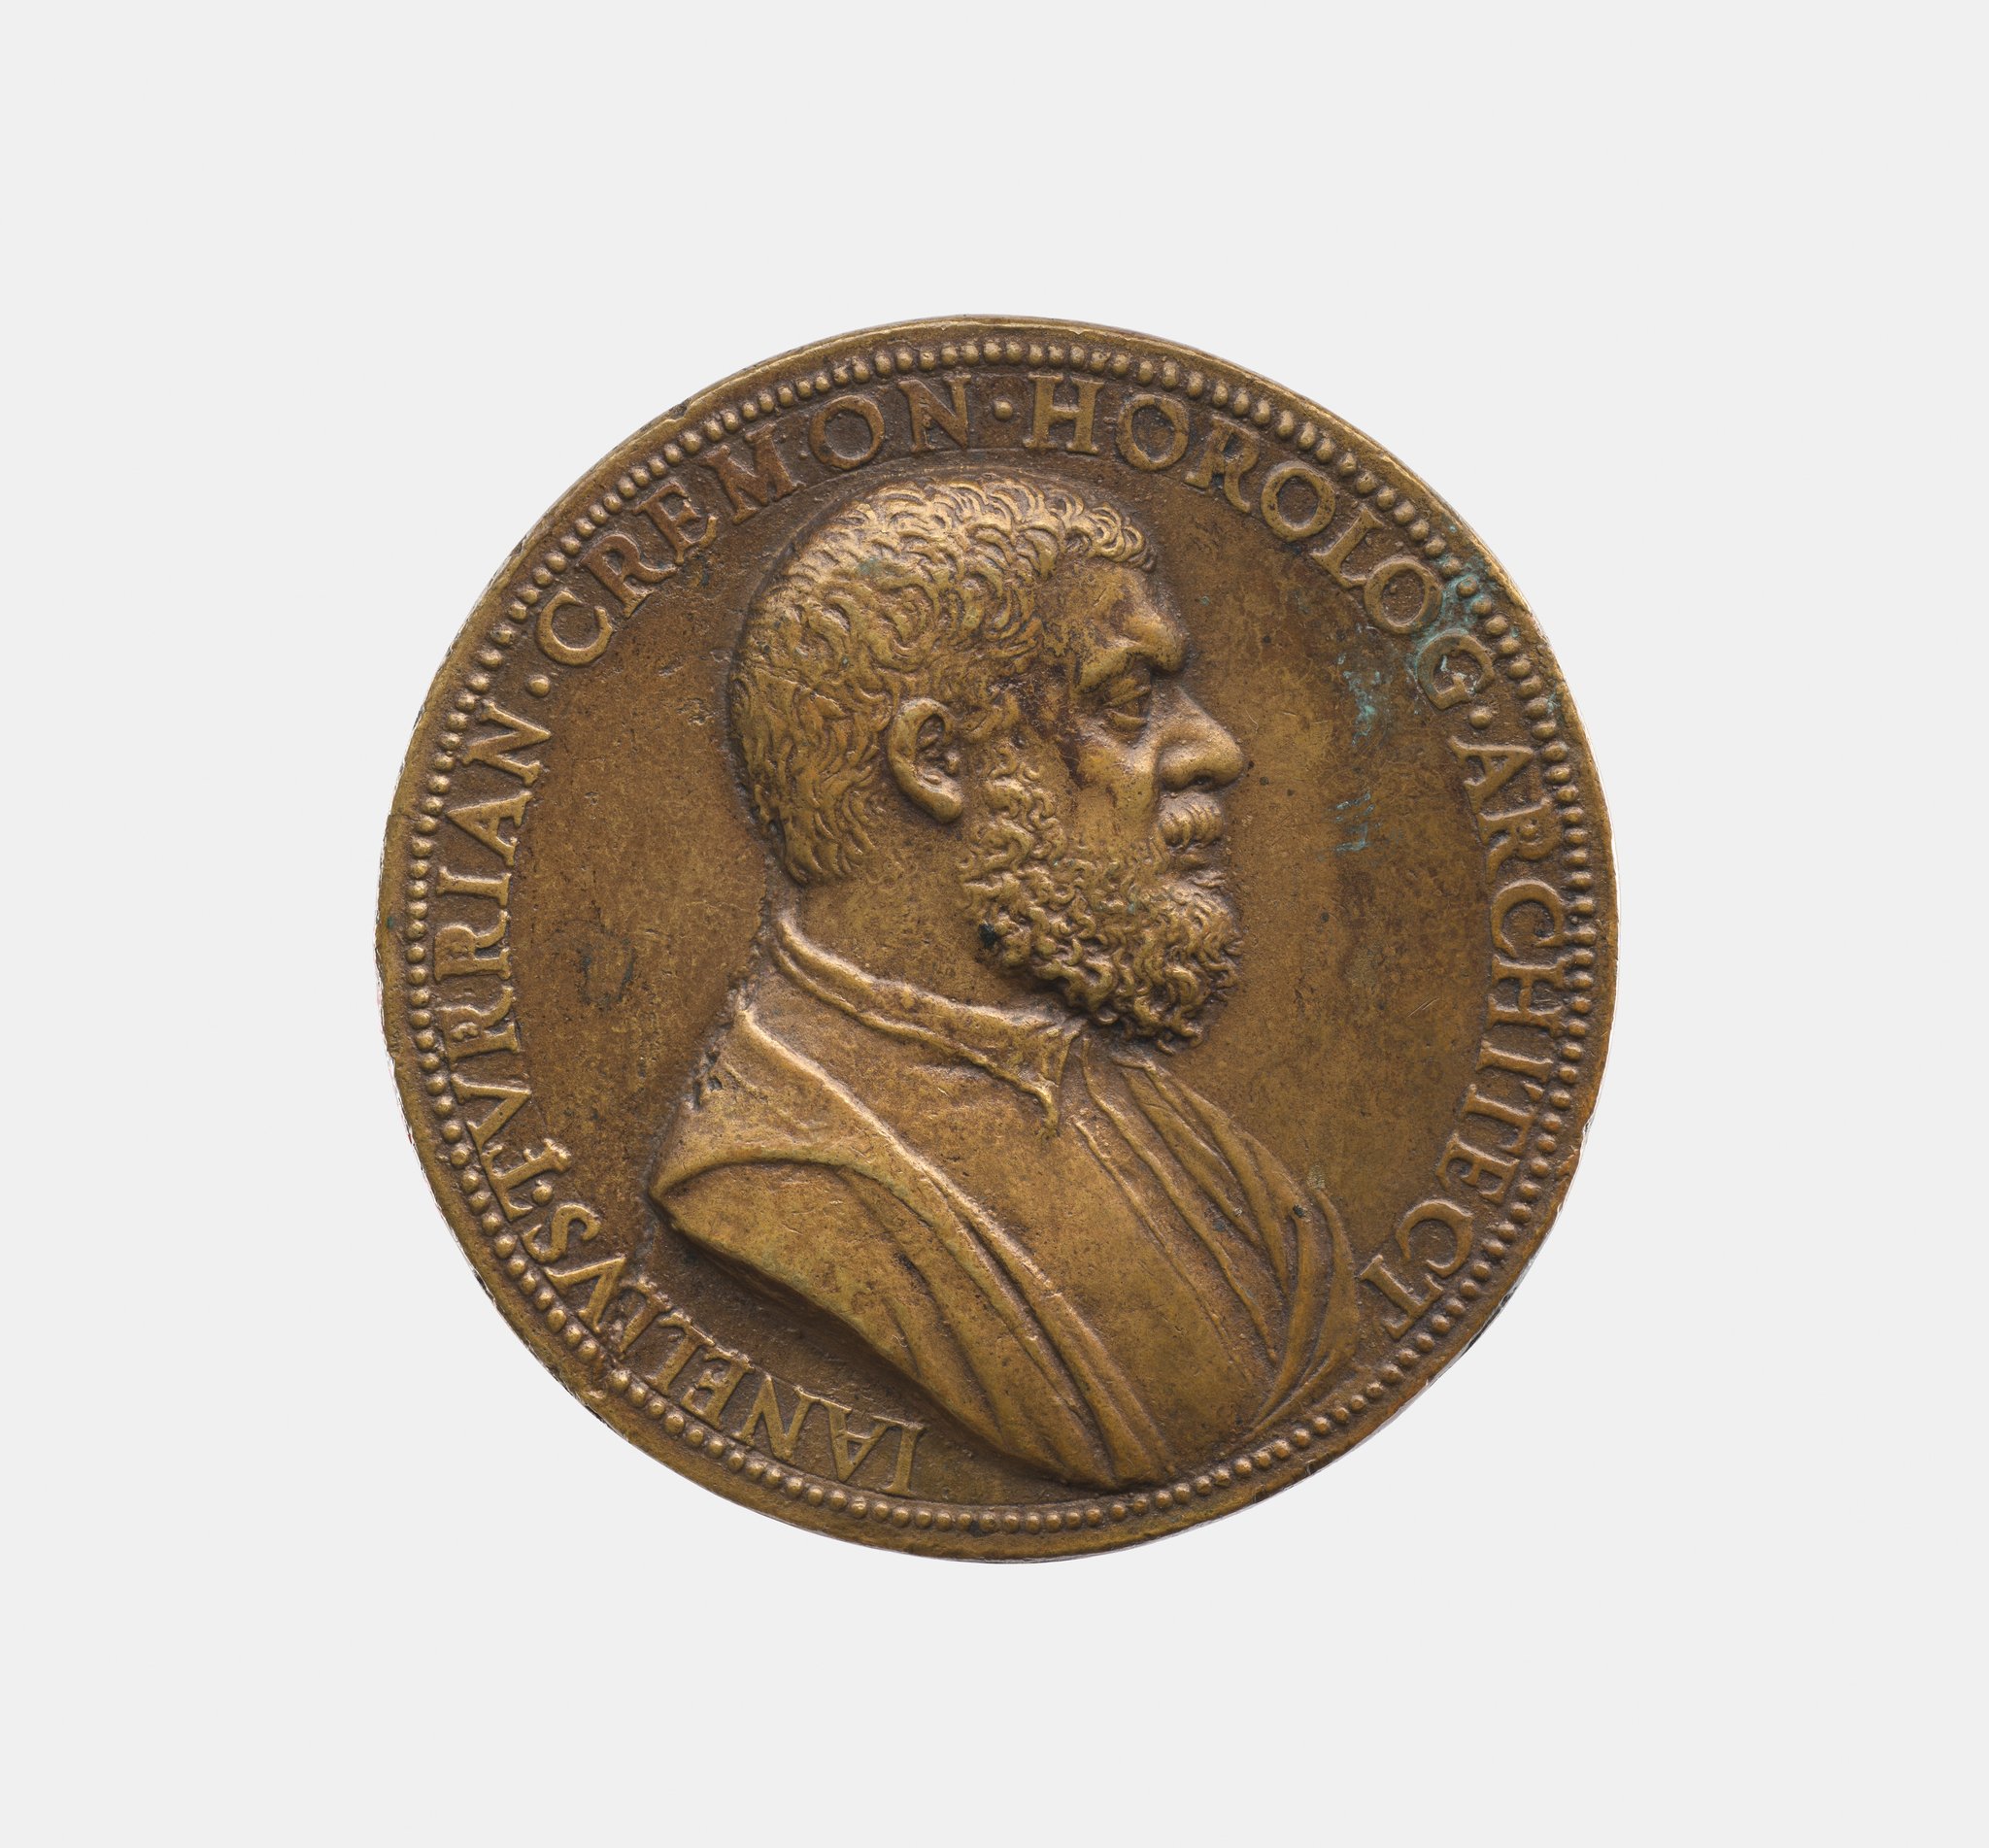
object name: medal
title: Gianello della Torre 1500-85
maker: leone leoni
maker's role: artist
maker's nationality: italian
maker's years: 1504-1590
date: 1519-1590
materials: bronze